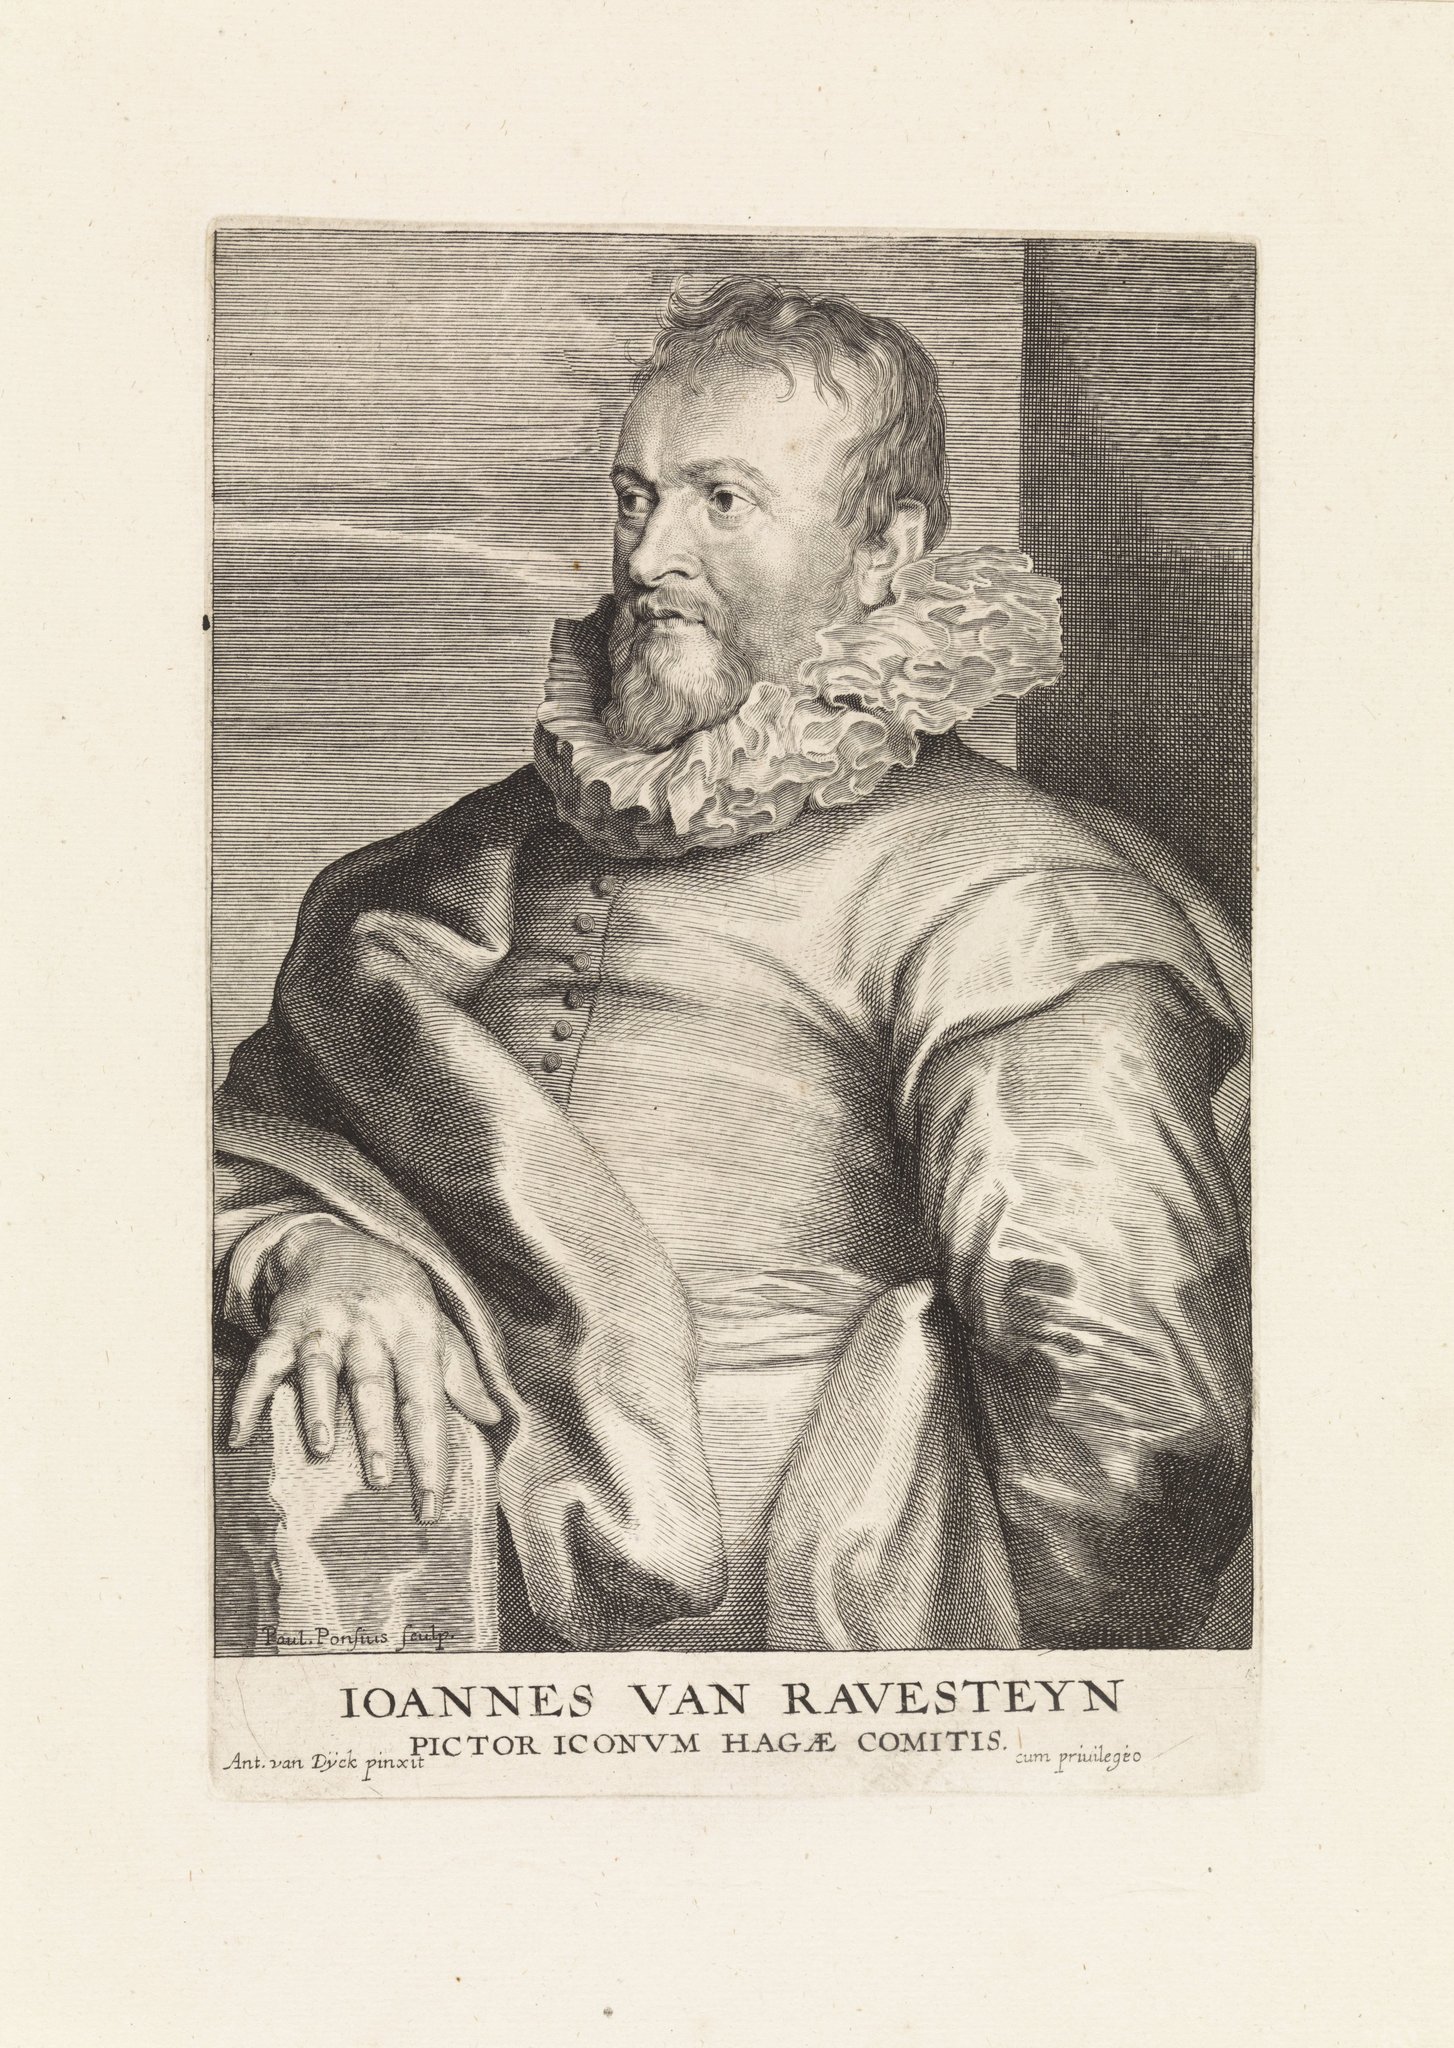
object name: print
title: Portret van de schilder Jan Antonisz. van Ravesteyn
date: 1616-1657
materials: paper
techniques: engraving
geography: antwerp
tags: the hague, painter, draughtsman, jan antonisz van ravesteyn, portrait, self-portrait of painter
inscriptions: collector's mark: Lugt 240